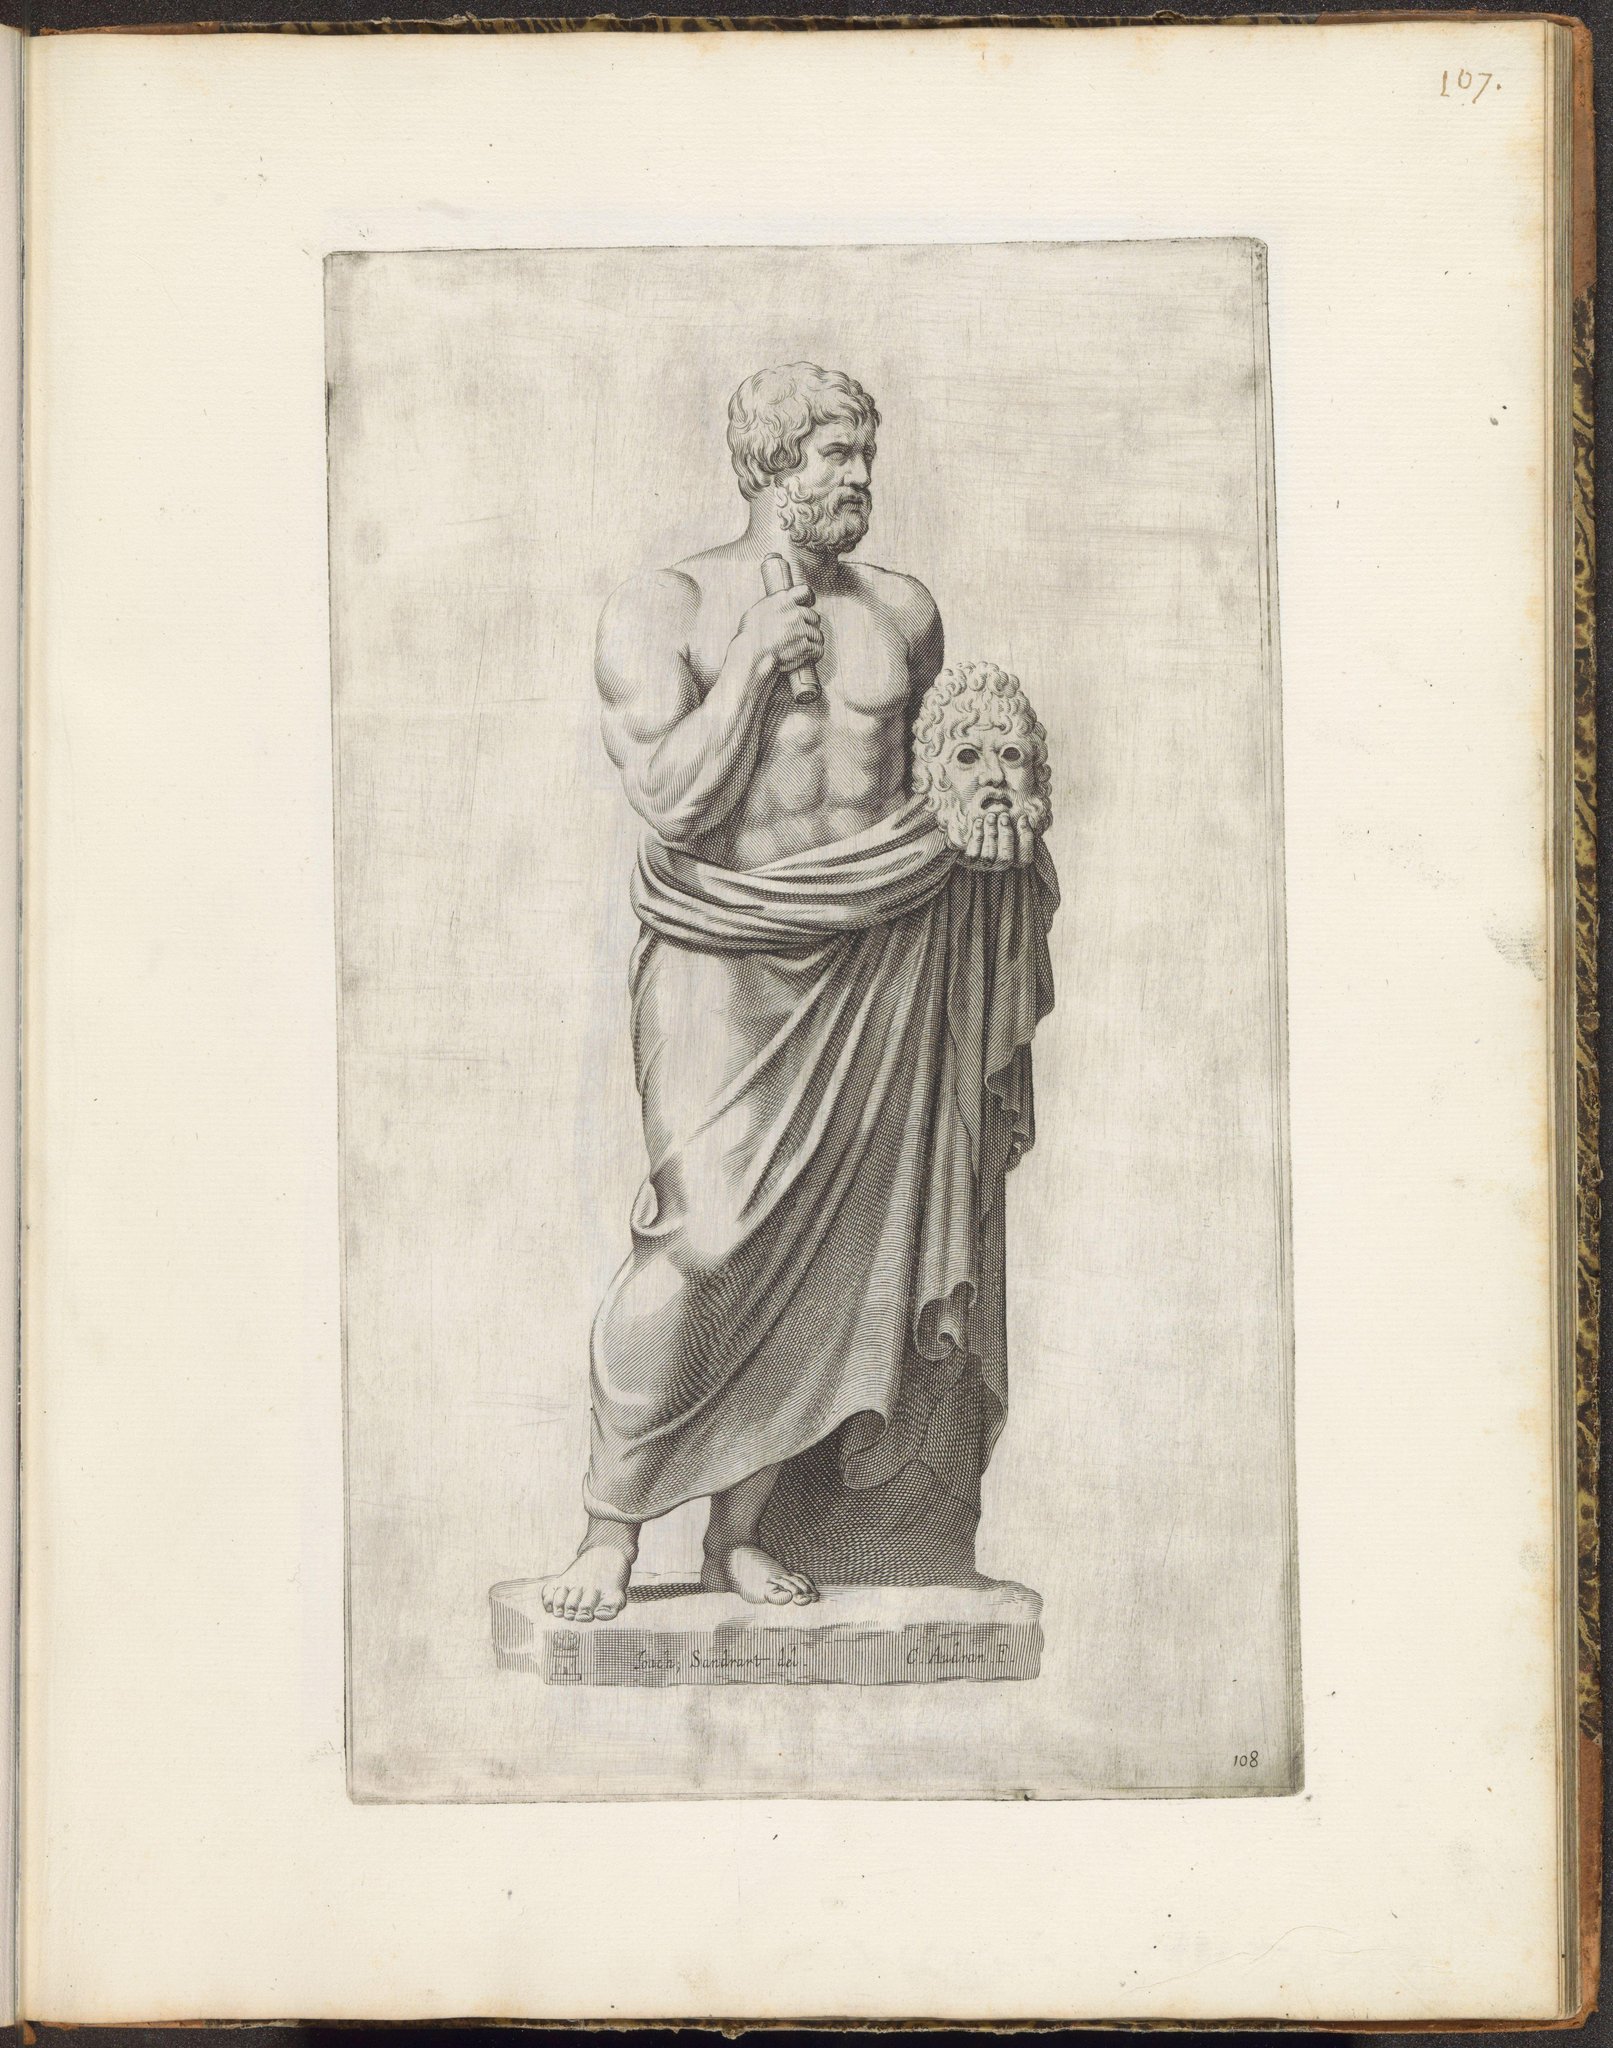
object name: print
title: Galleria Giustiniana del Marchese Vincenzo Giustiniani I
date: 1636-1647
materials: paper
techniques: engraving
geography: rome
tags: mask, piece of sculpture, reproduction of a piece of sculpture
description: Standbeeld van een man met masker in de hand, mogelijk de blijspeldichter Publius Terentius Afer. Op de basis het wapenschild van Vincenzo Giustiniani. Prent maakt deel uit van een album met een serie prenten naar de sculpturen in de verzameling in de Galleria Giustiniani te Rome.